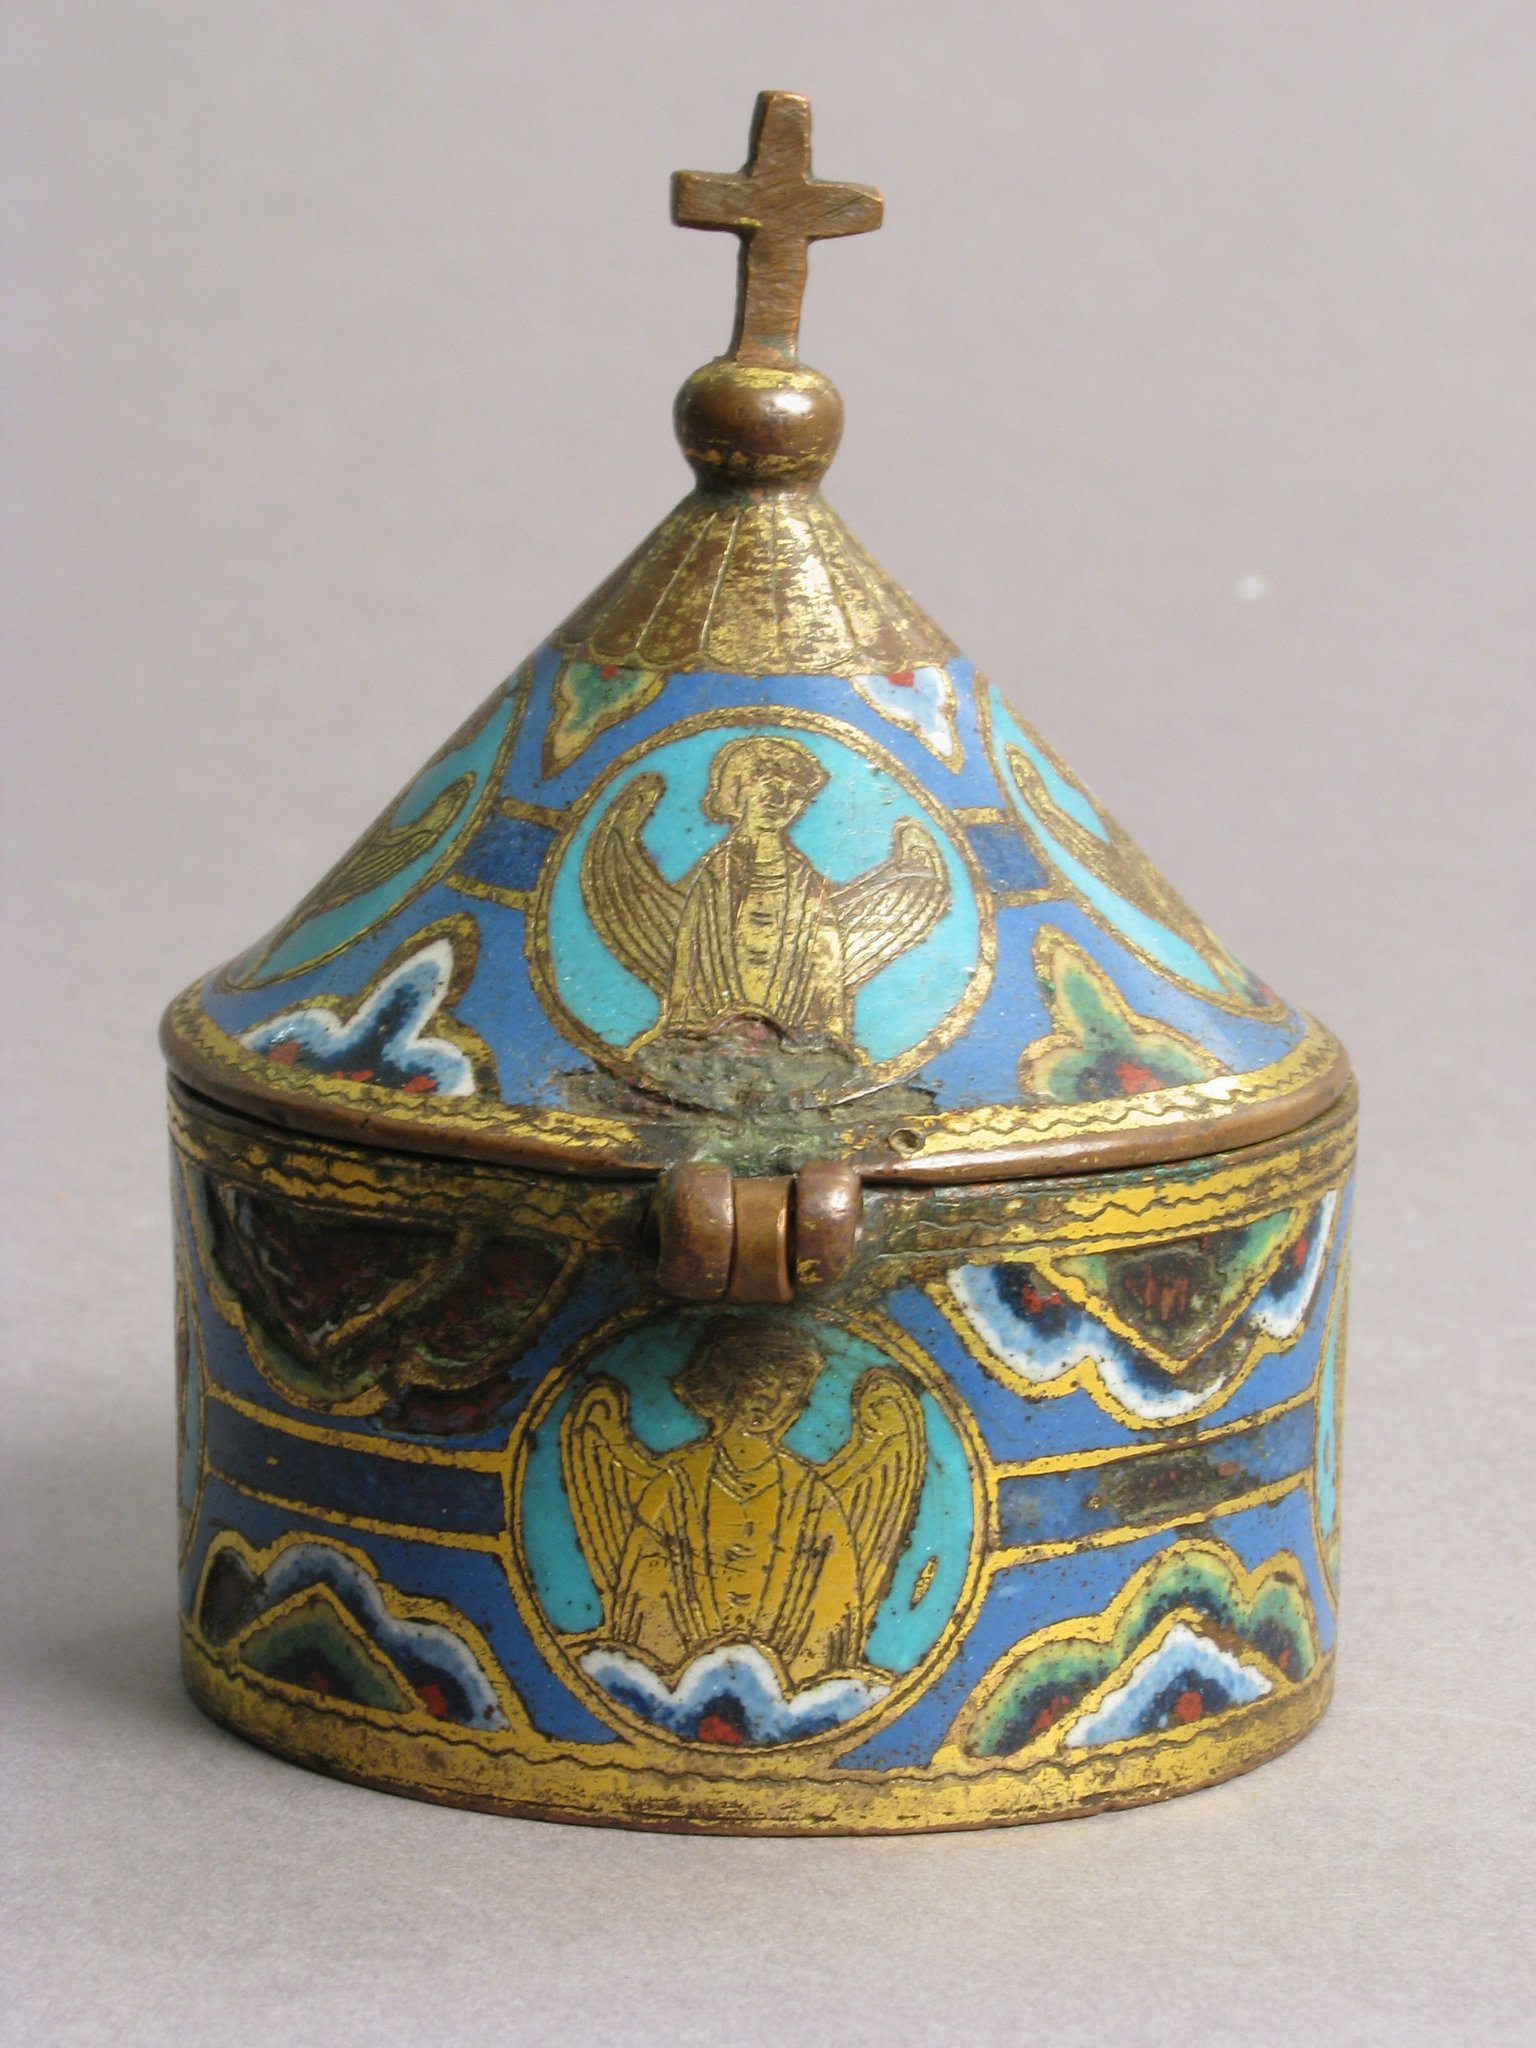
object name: pyx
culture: french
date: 1225-1250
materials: copper, enamel, gilt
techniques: enamel, engraving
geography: france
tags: angels,cross